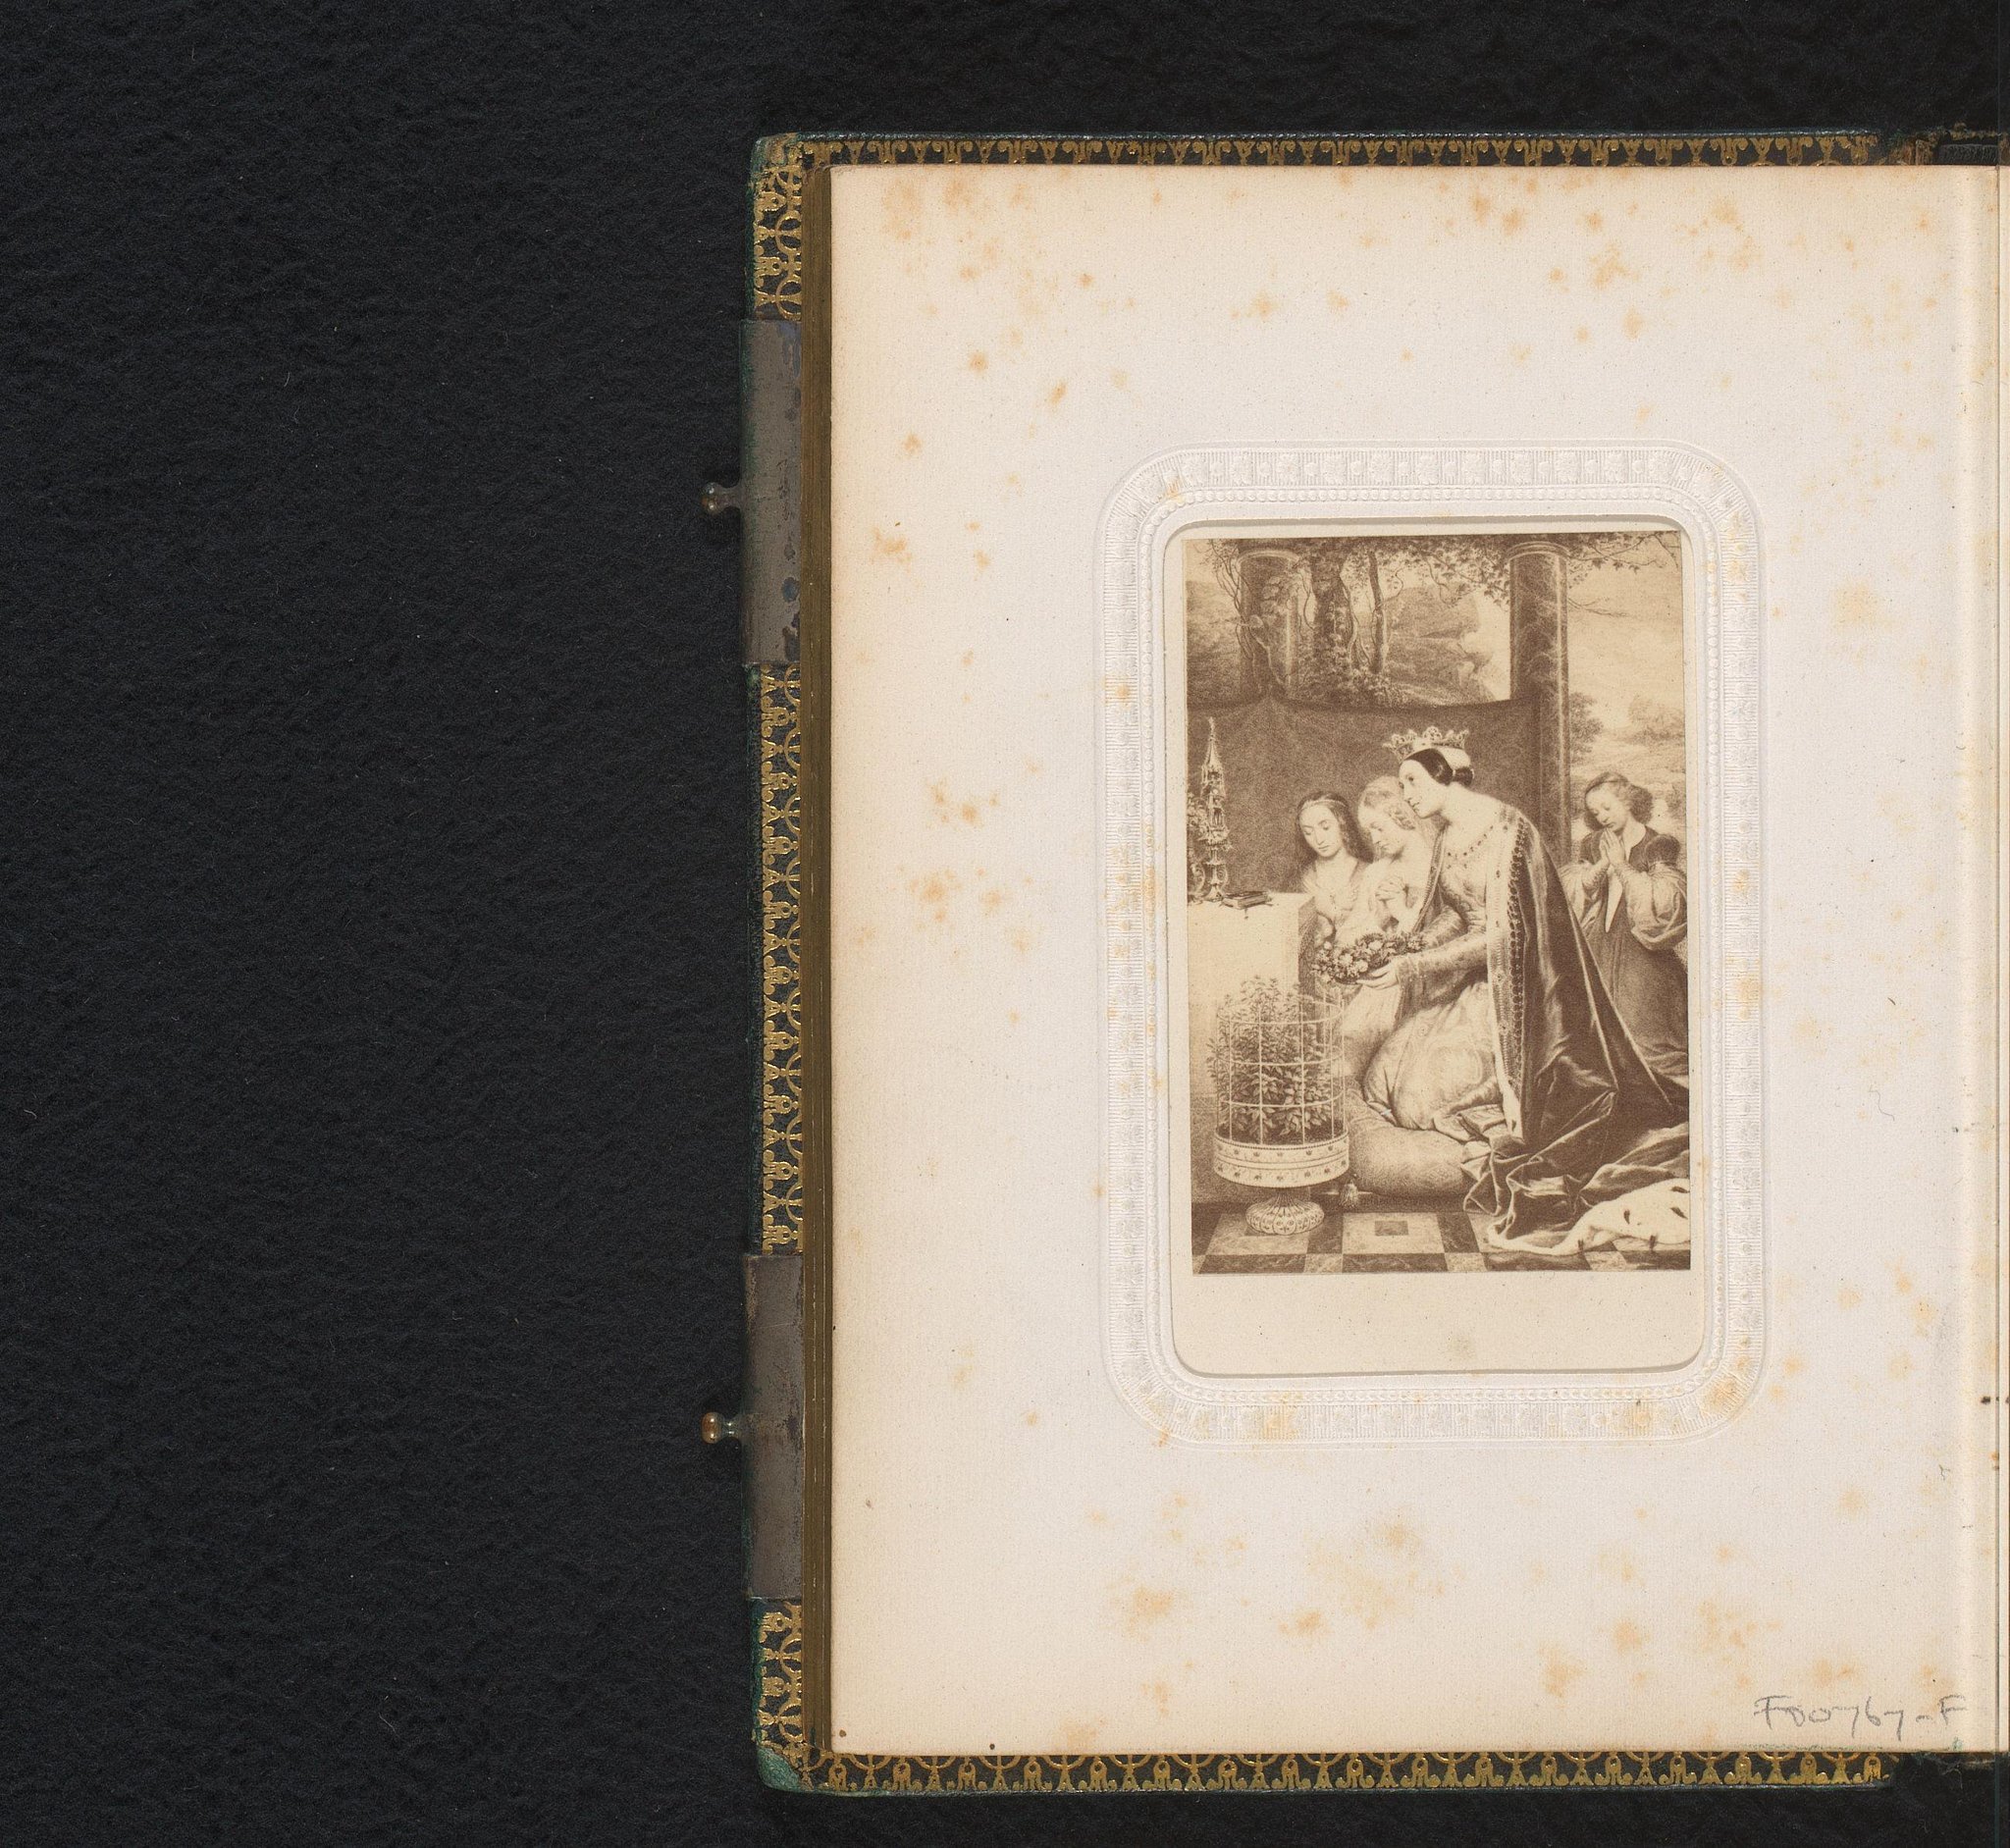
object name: carte de visite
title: Fotoreproductie van Sainte Amélie Reine de Hongrie door Paul Delaroche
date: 1861-1878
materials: cardboard, photographic support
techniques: albumen print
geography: paris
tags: queen, relics (and reliquaries)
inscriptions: inscription: ‘PHOTOGRAPHIE GOUPIL & Cie/ PARIS, 19, Bd Montmartre./ LONDRES-LA HAYE-BERLIN-NEW YORK’